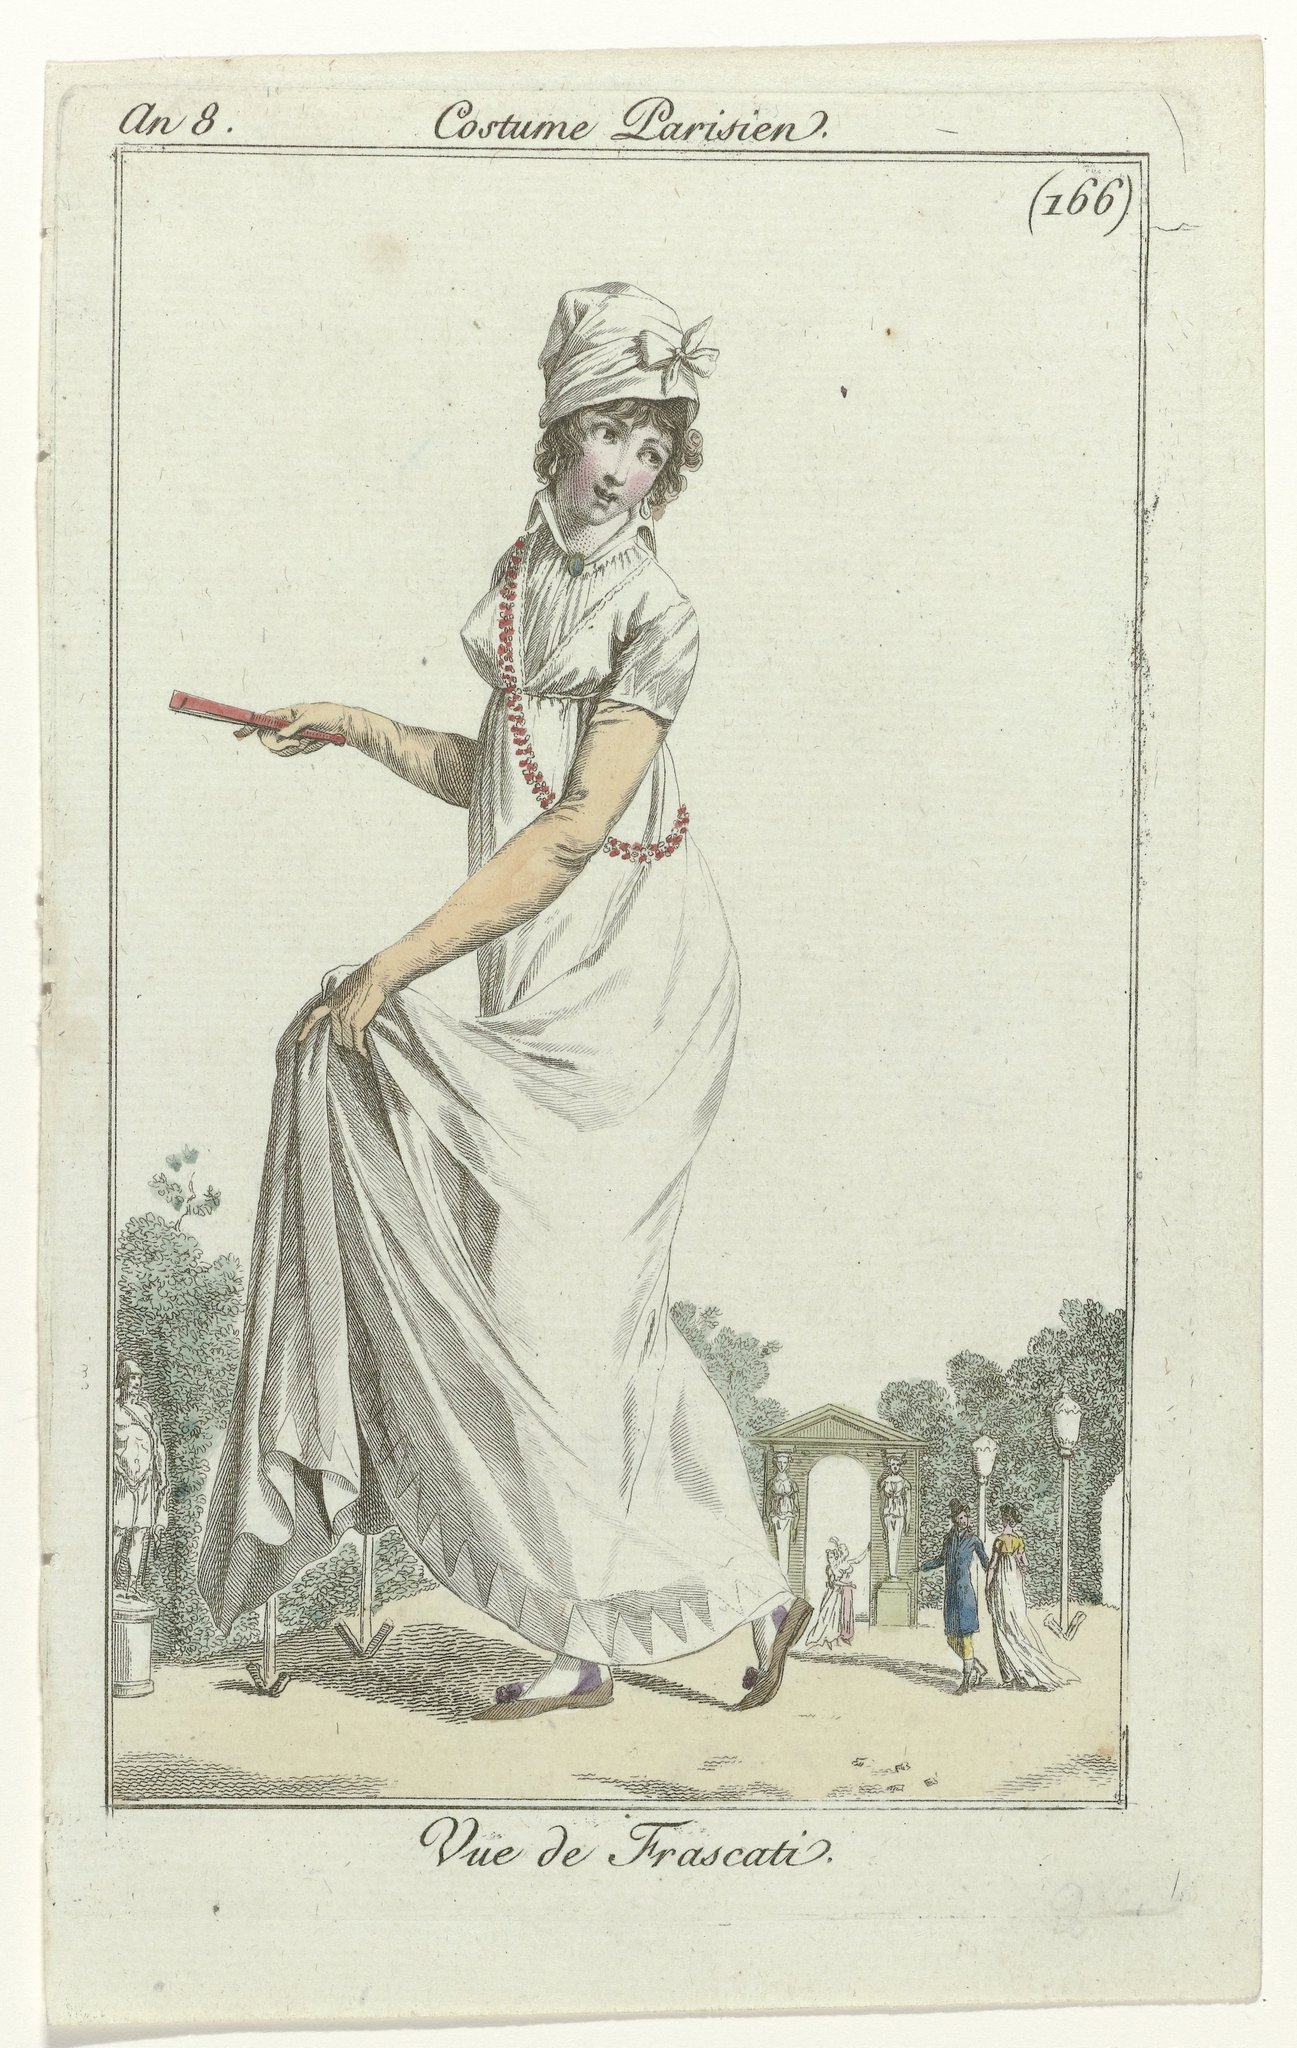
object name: fashion print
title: Journal des Dames et des Modes, Costume Parisien, 22 octobre 1799, An 8 (166) : Vue de Frascati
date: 1799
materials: paper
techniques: engraving, hand coloring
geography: paris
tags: ear-rings (+ women's clothes), gloves, mittens (long gloves) (+ women's clothes), head-gear (+ women's clothes), fashion plates, shoes, sandals (+ women's clothes), dress, gown (+ women's clothes), stockings, socks (+ women's clothes), fan (+ women's clothes), necklace (+ women's clothes), public gardens, park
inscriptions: caption: ‘Vue de Frascati’, title: ‘Costume Parisien.’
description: Japon met korte mouwen, afgezet met zig-zag motief. Doek om het hoofd geknoopt. Kousen met contrasterende klinken. Verdere accessoires: oorbellen, broche (?), lang collier schuin over de borst, lange handschoenen, waaier, platte schoenen met puntige neuzen. De prent maakt deel uit van het modetijdschrift Journal des Dames et des Modes, uitgegeven door Pierre de la Mésangère, Parijs, 1797-1839.